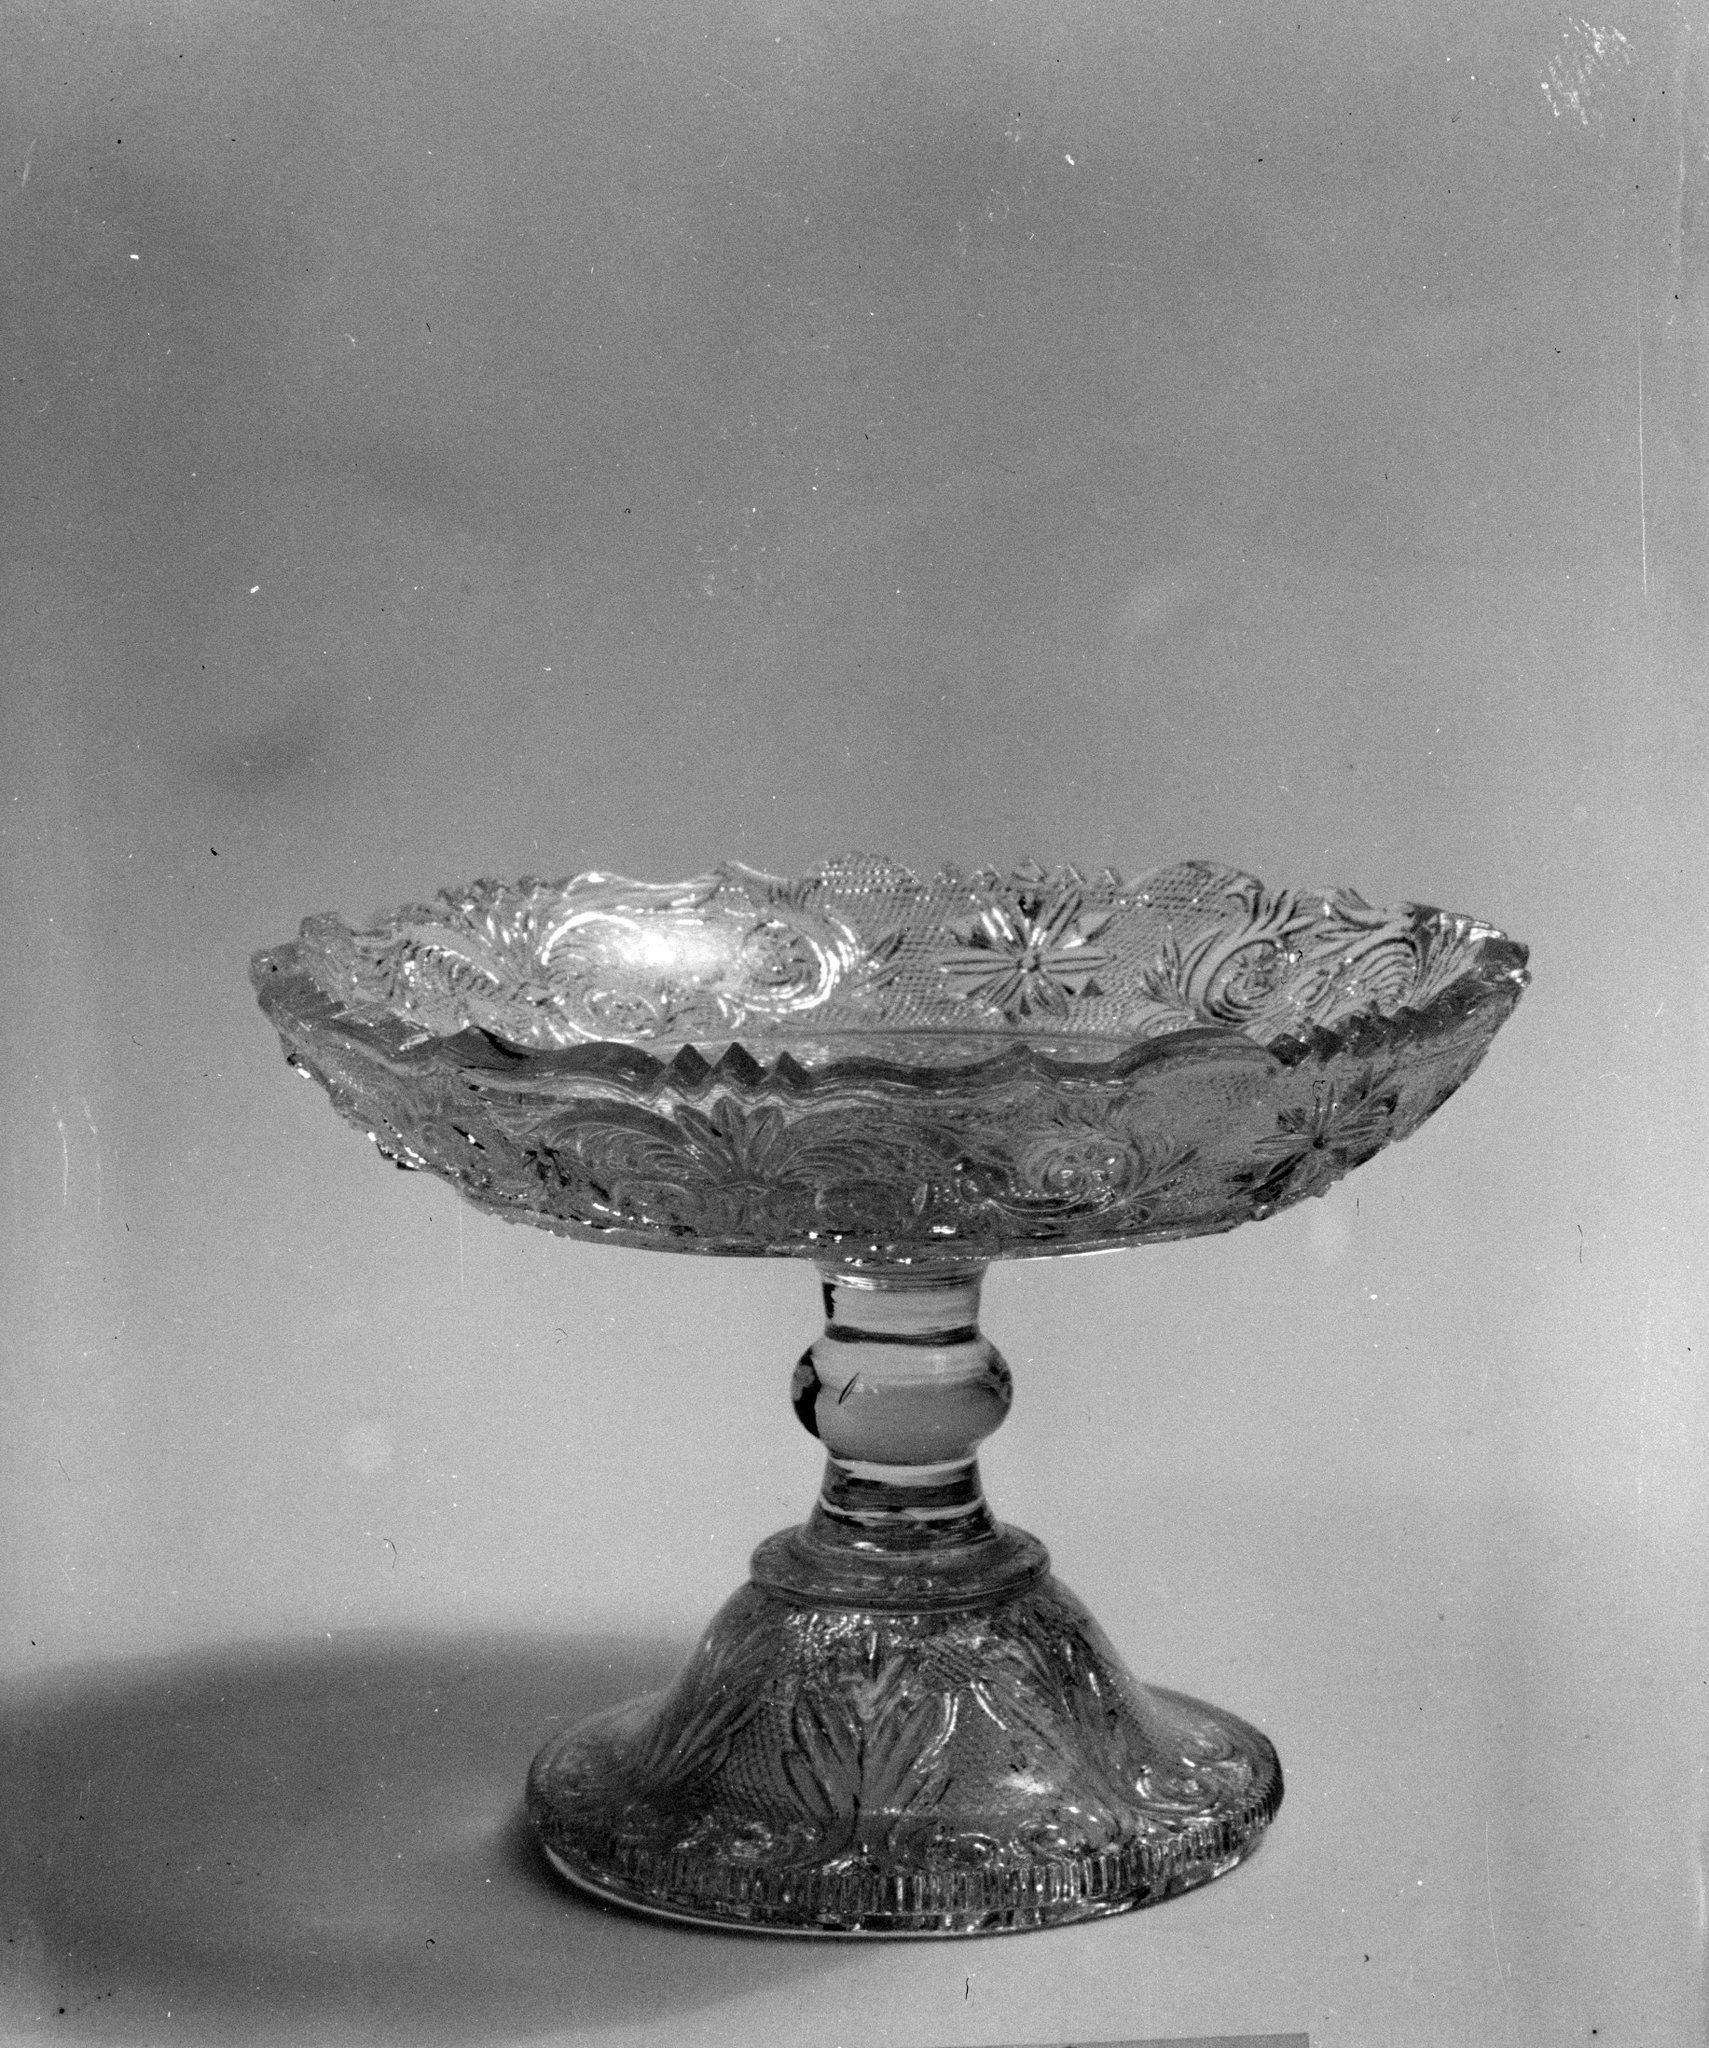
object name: compote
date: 1801-1900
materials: glass